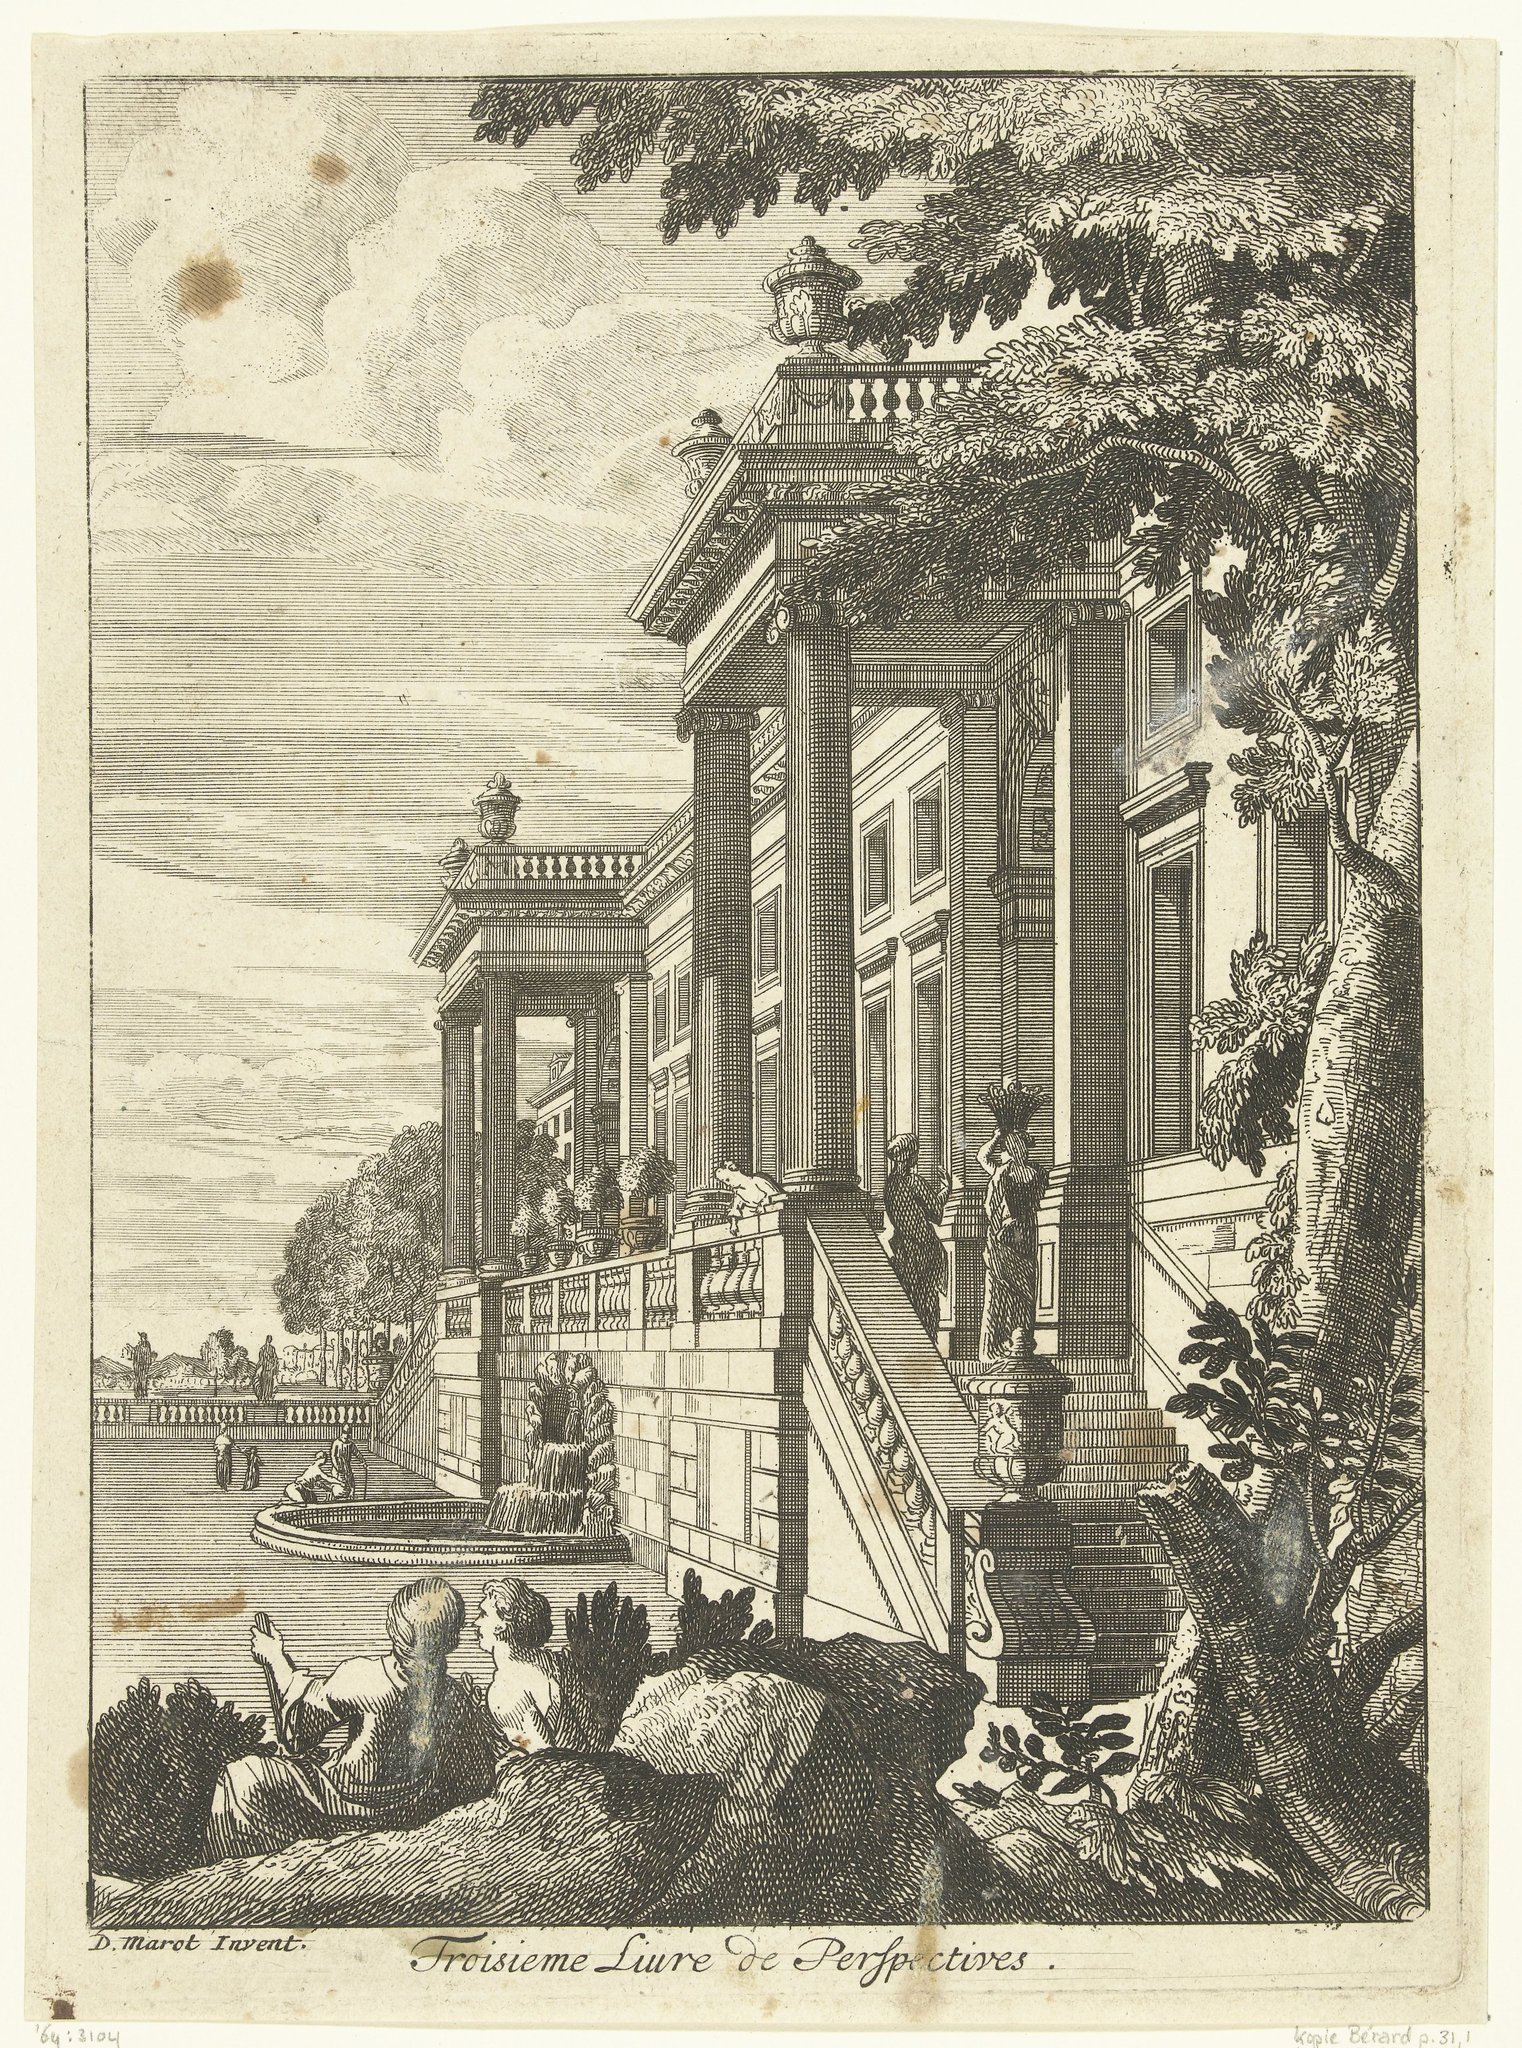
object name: titelblad, titelpagina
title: Titelblad: Troisieme Liure de Perspectives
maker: Anonymous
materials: paper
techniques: etching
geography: netherlands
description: Gevel van paleis met overloop, rechts vooraan staat een boom. Tegenzijdige kopie naar prent uit serie Troisième Lieure de perspectives.